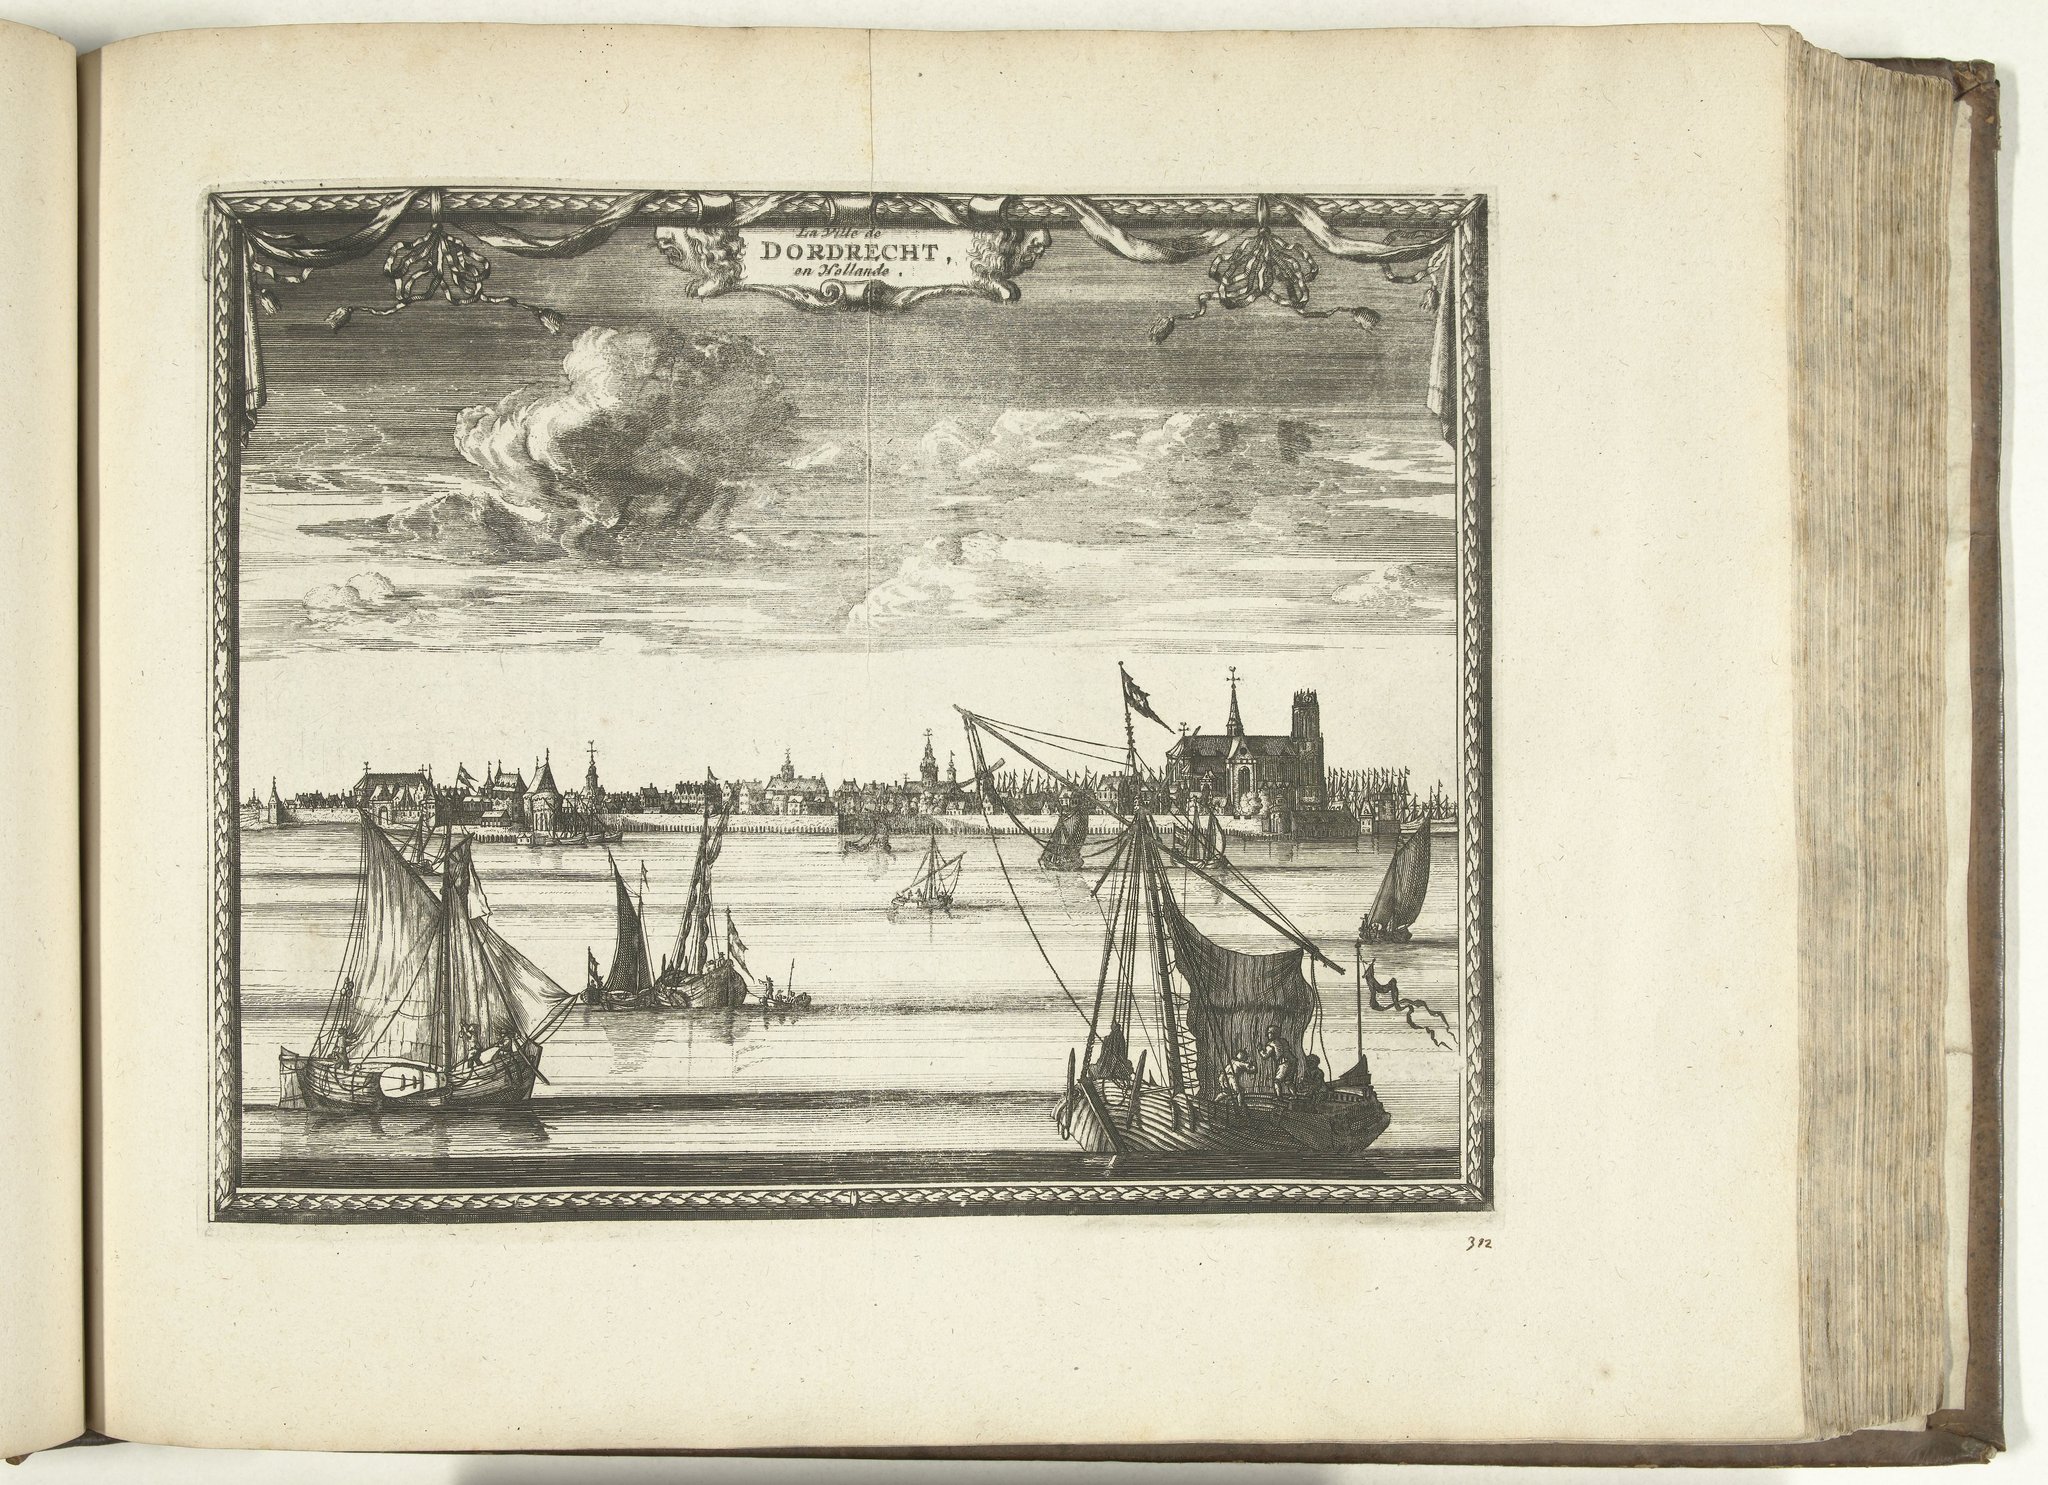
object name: print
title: Les Forces de l'Europe, Asie, Afrique et Amerique (...) Comme aussi les Cartes des Côtes de France et d'Espagne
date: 1726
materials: paper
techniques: etching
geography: northern netherlands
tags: dordrecht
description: Gezicht op Dordrecht, op de voorgrond enkele vissersboten. Plaat nr. 312 in deel XIII van het prentwerk: Les Forces de l'Europe, Asie, Afrique et Amerique ... Comme aussi les Cartes des Côtes de France et d'Espagne uit 1726, dit tweede deel met 271 met de hand genummerde platen van vermaarde sterke steden en vestingen in het kader van de Spaanse Successieoorlog 1701-1713. Voor het merendeel zijn deze platen gekopieerd naar de anonieme Franse platen van vermaarde sterke steden en vestingen: in Les forces de l'Europe en in: Le theatre de la guerre, dans les Pays-Bas, beide oorspronkelijk uitgegeven door Nicolas de Fer te Parijs (1693-1697) in het kader van de Negenjarige Oorlog. Titel in het Frans.